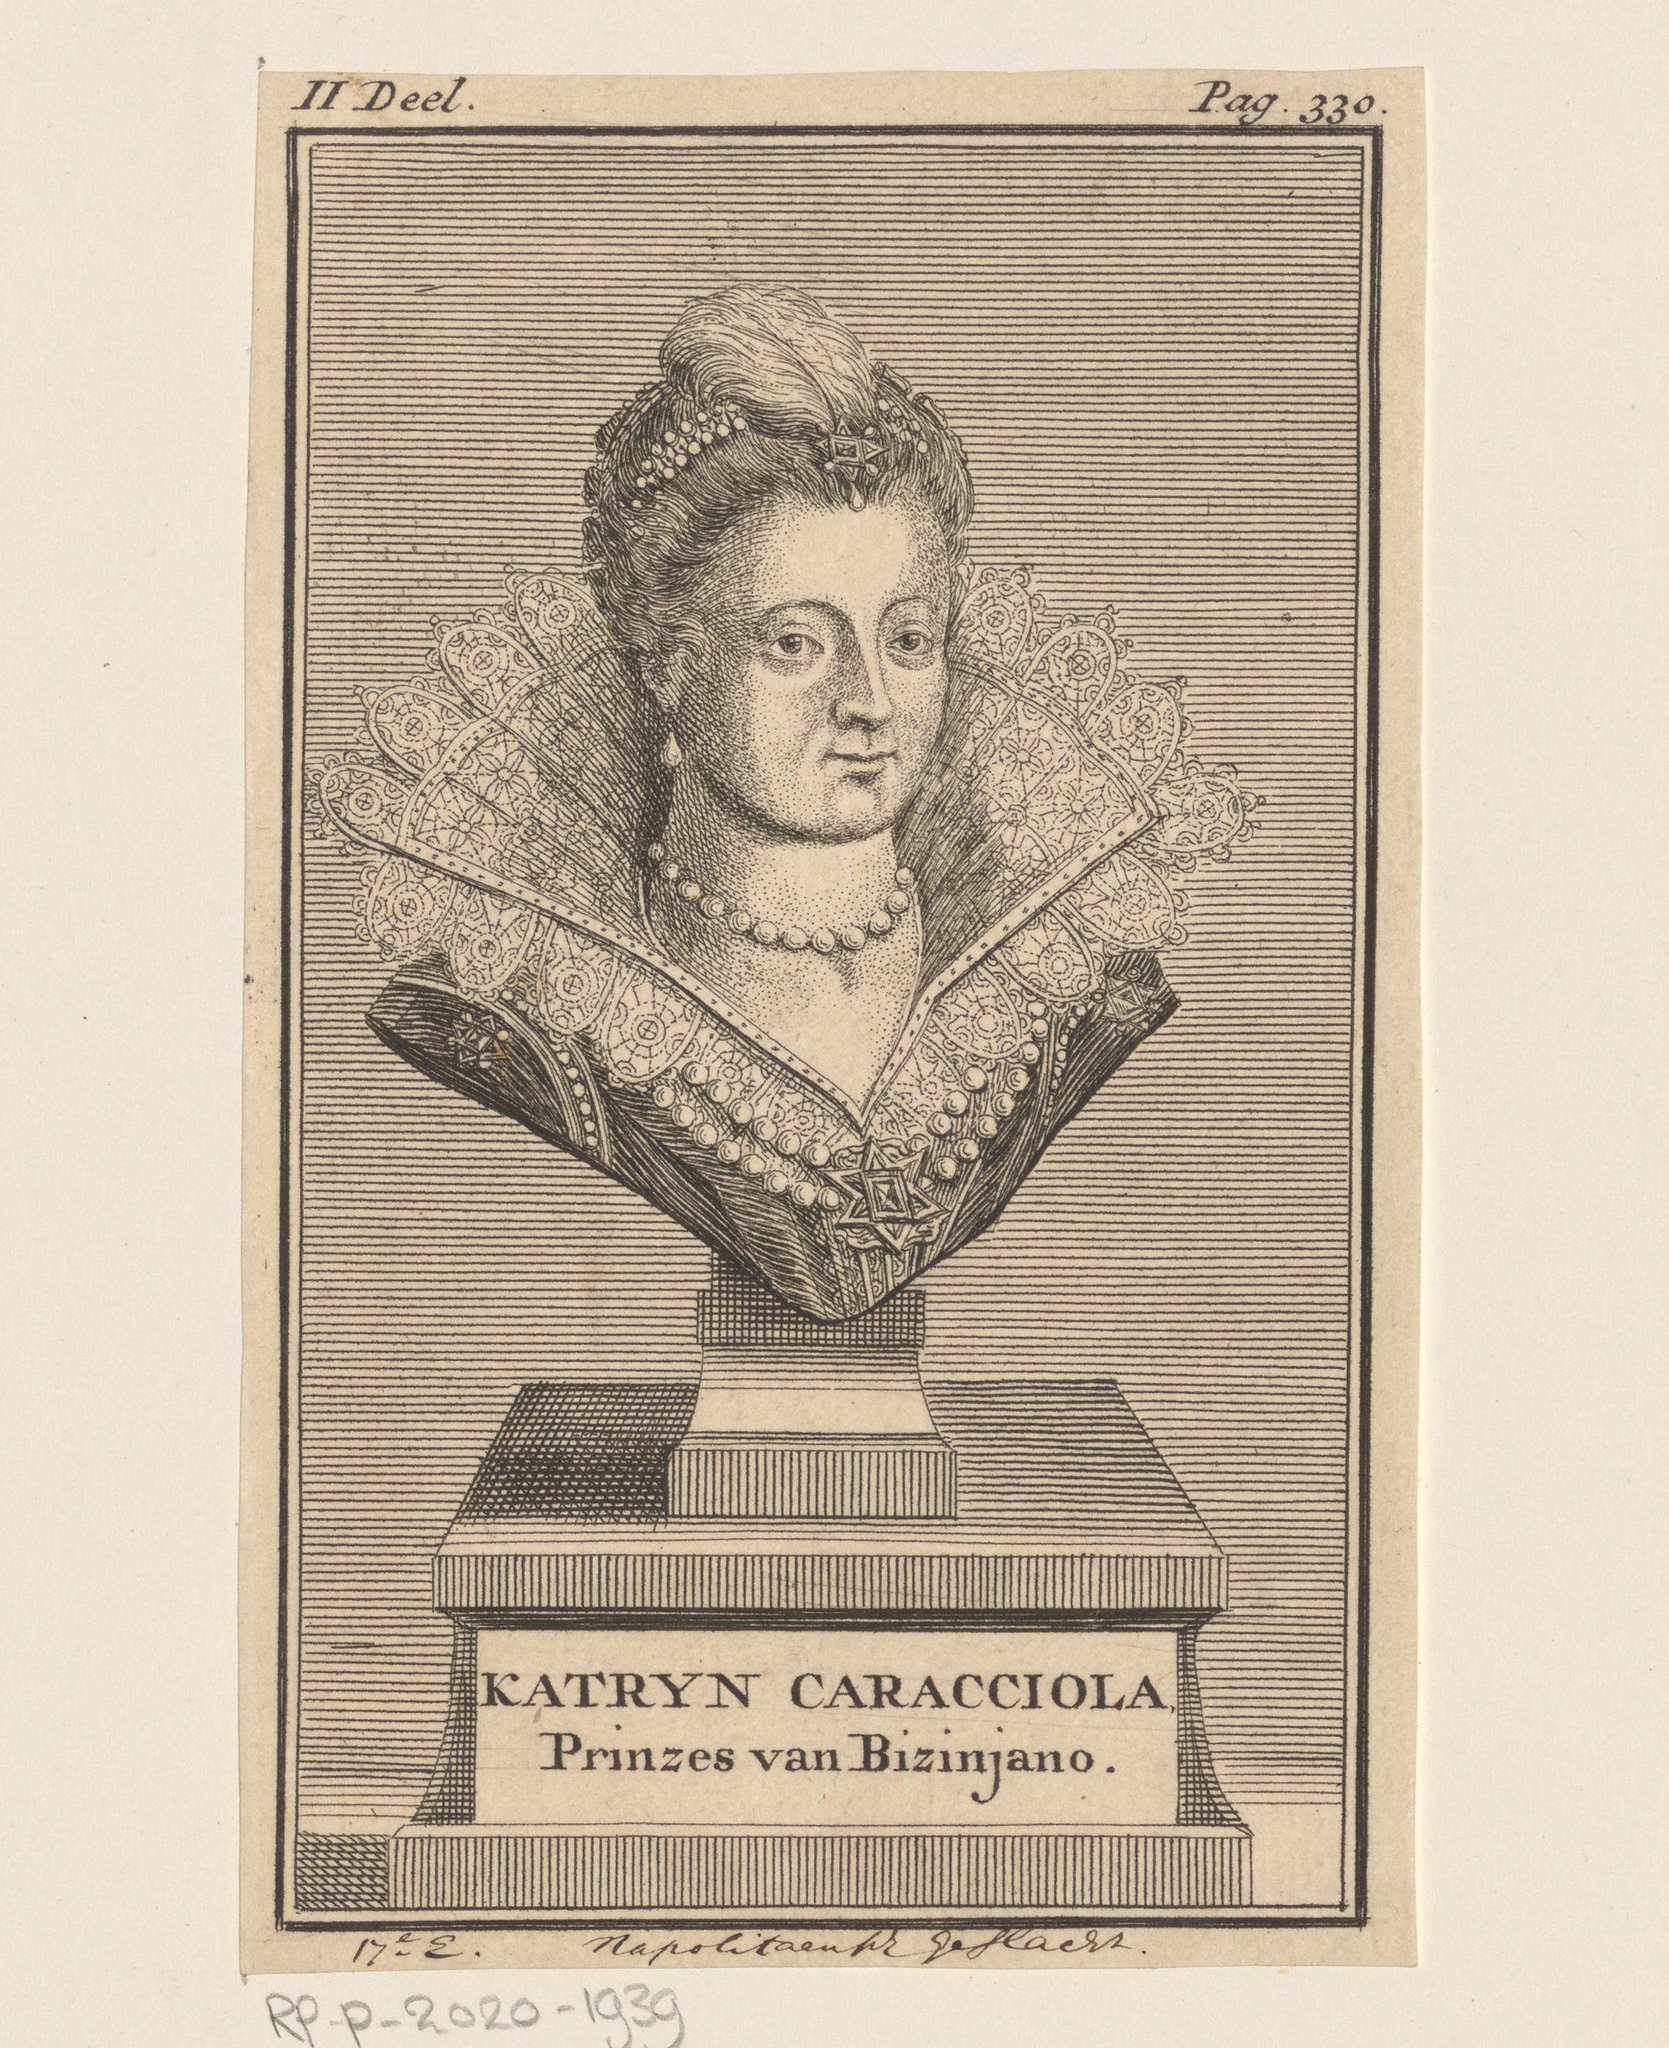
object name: print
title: Portret van Catharina Caracciola, prinses van Bisignano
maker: Anonymous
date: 1650-1699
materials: paper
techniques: engraving, etching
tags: historical persons - bb - woman